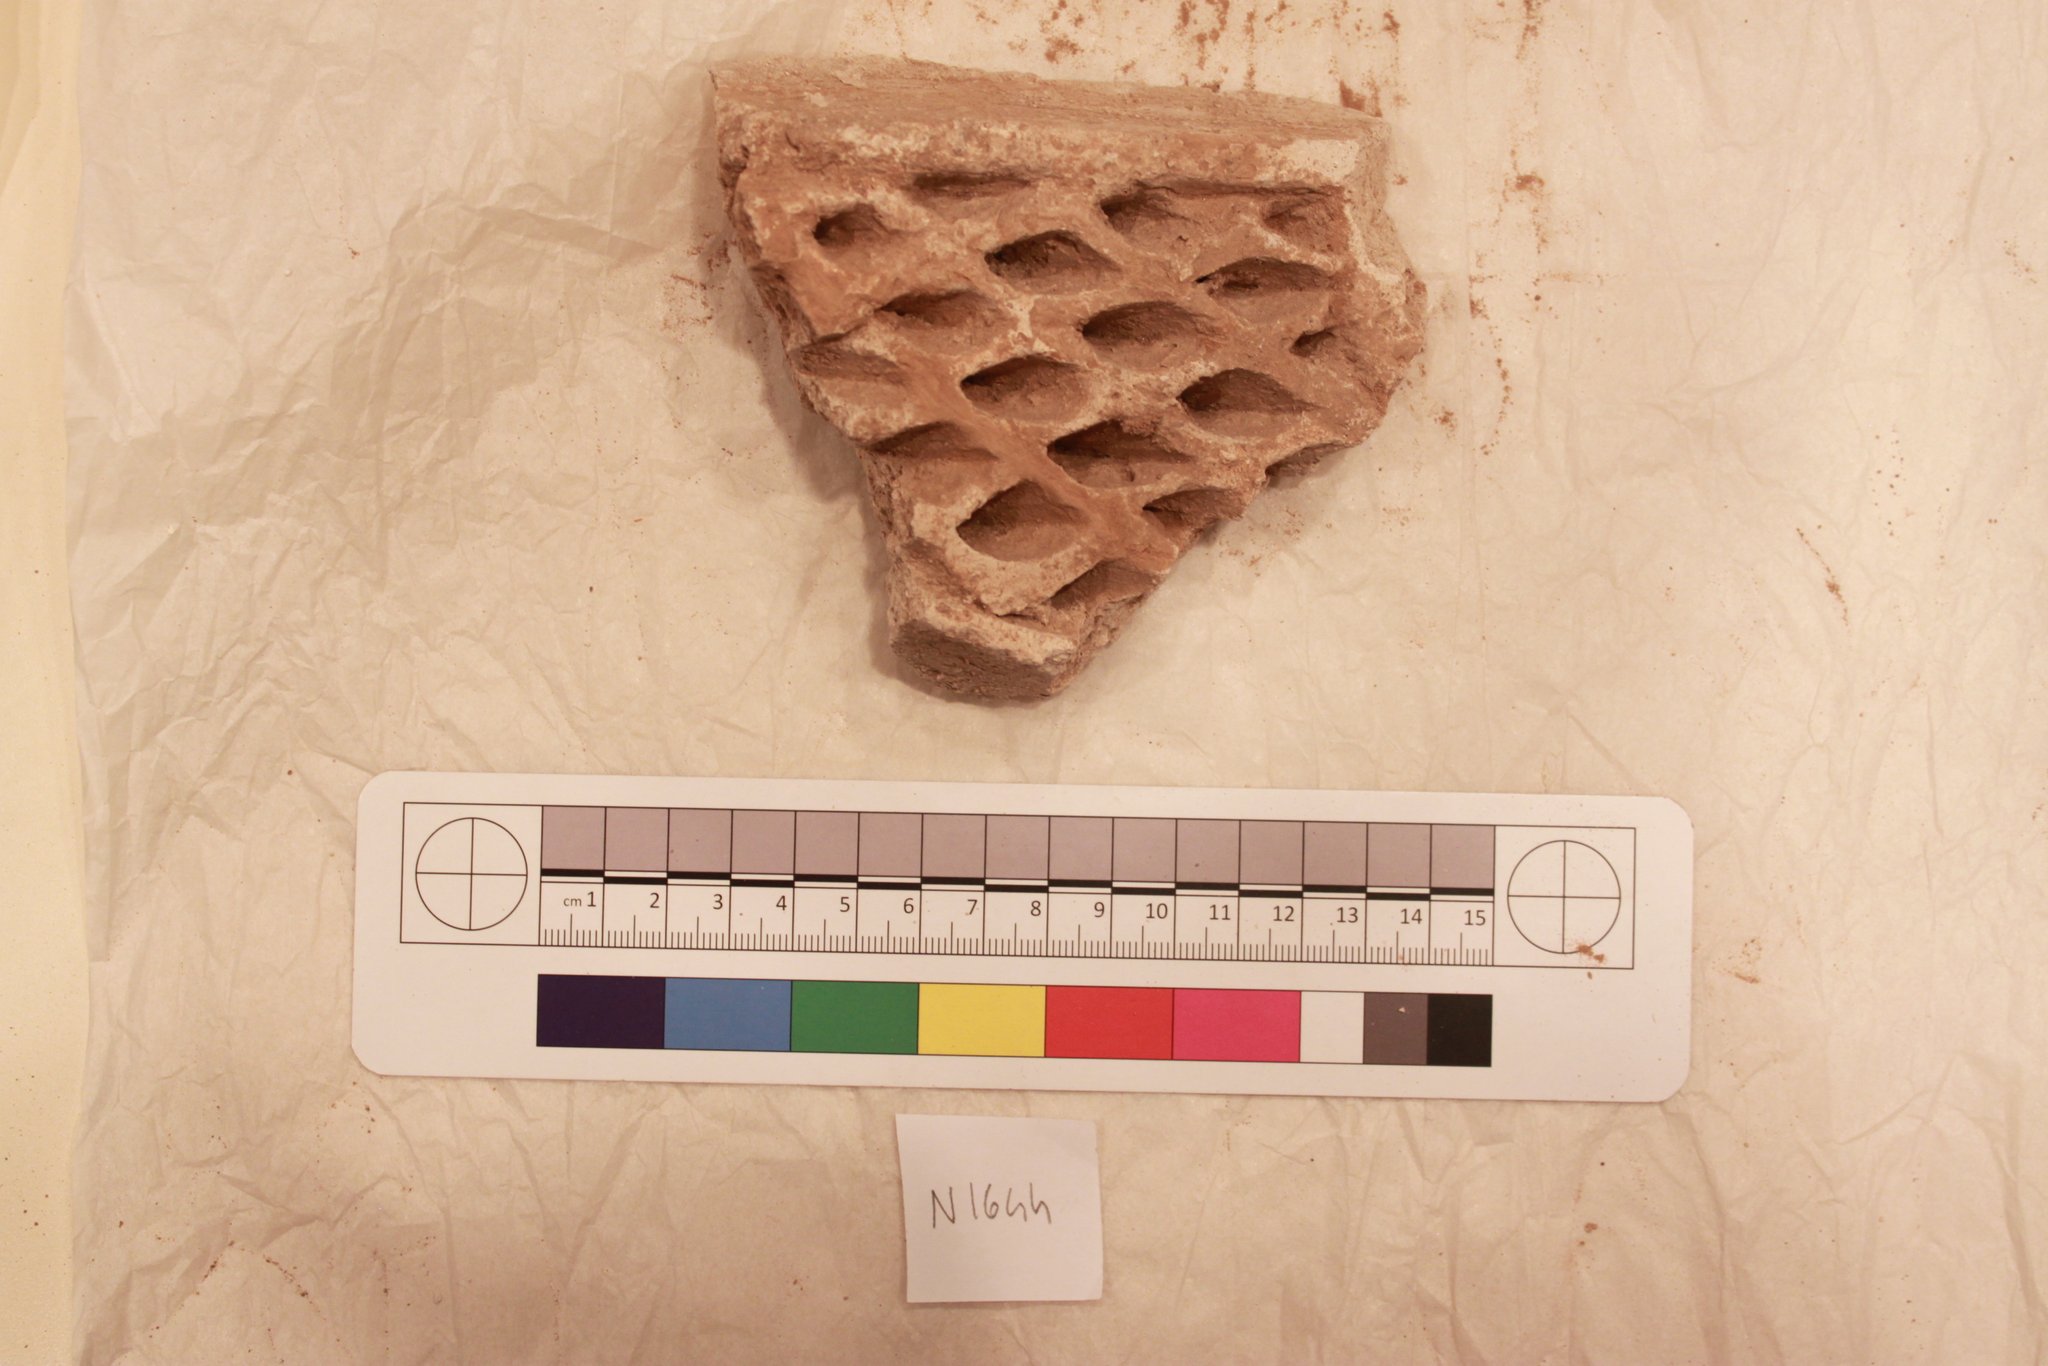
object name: fragment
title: Stucco Fragment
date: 701-1200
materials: plaster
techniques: carving, painting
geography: iran